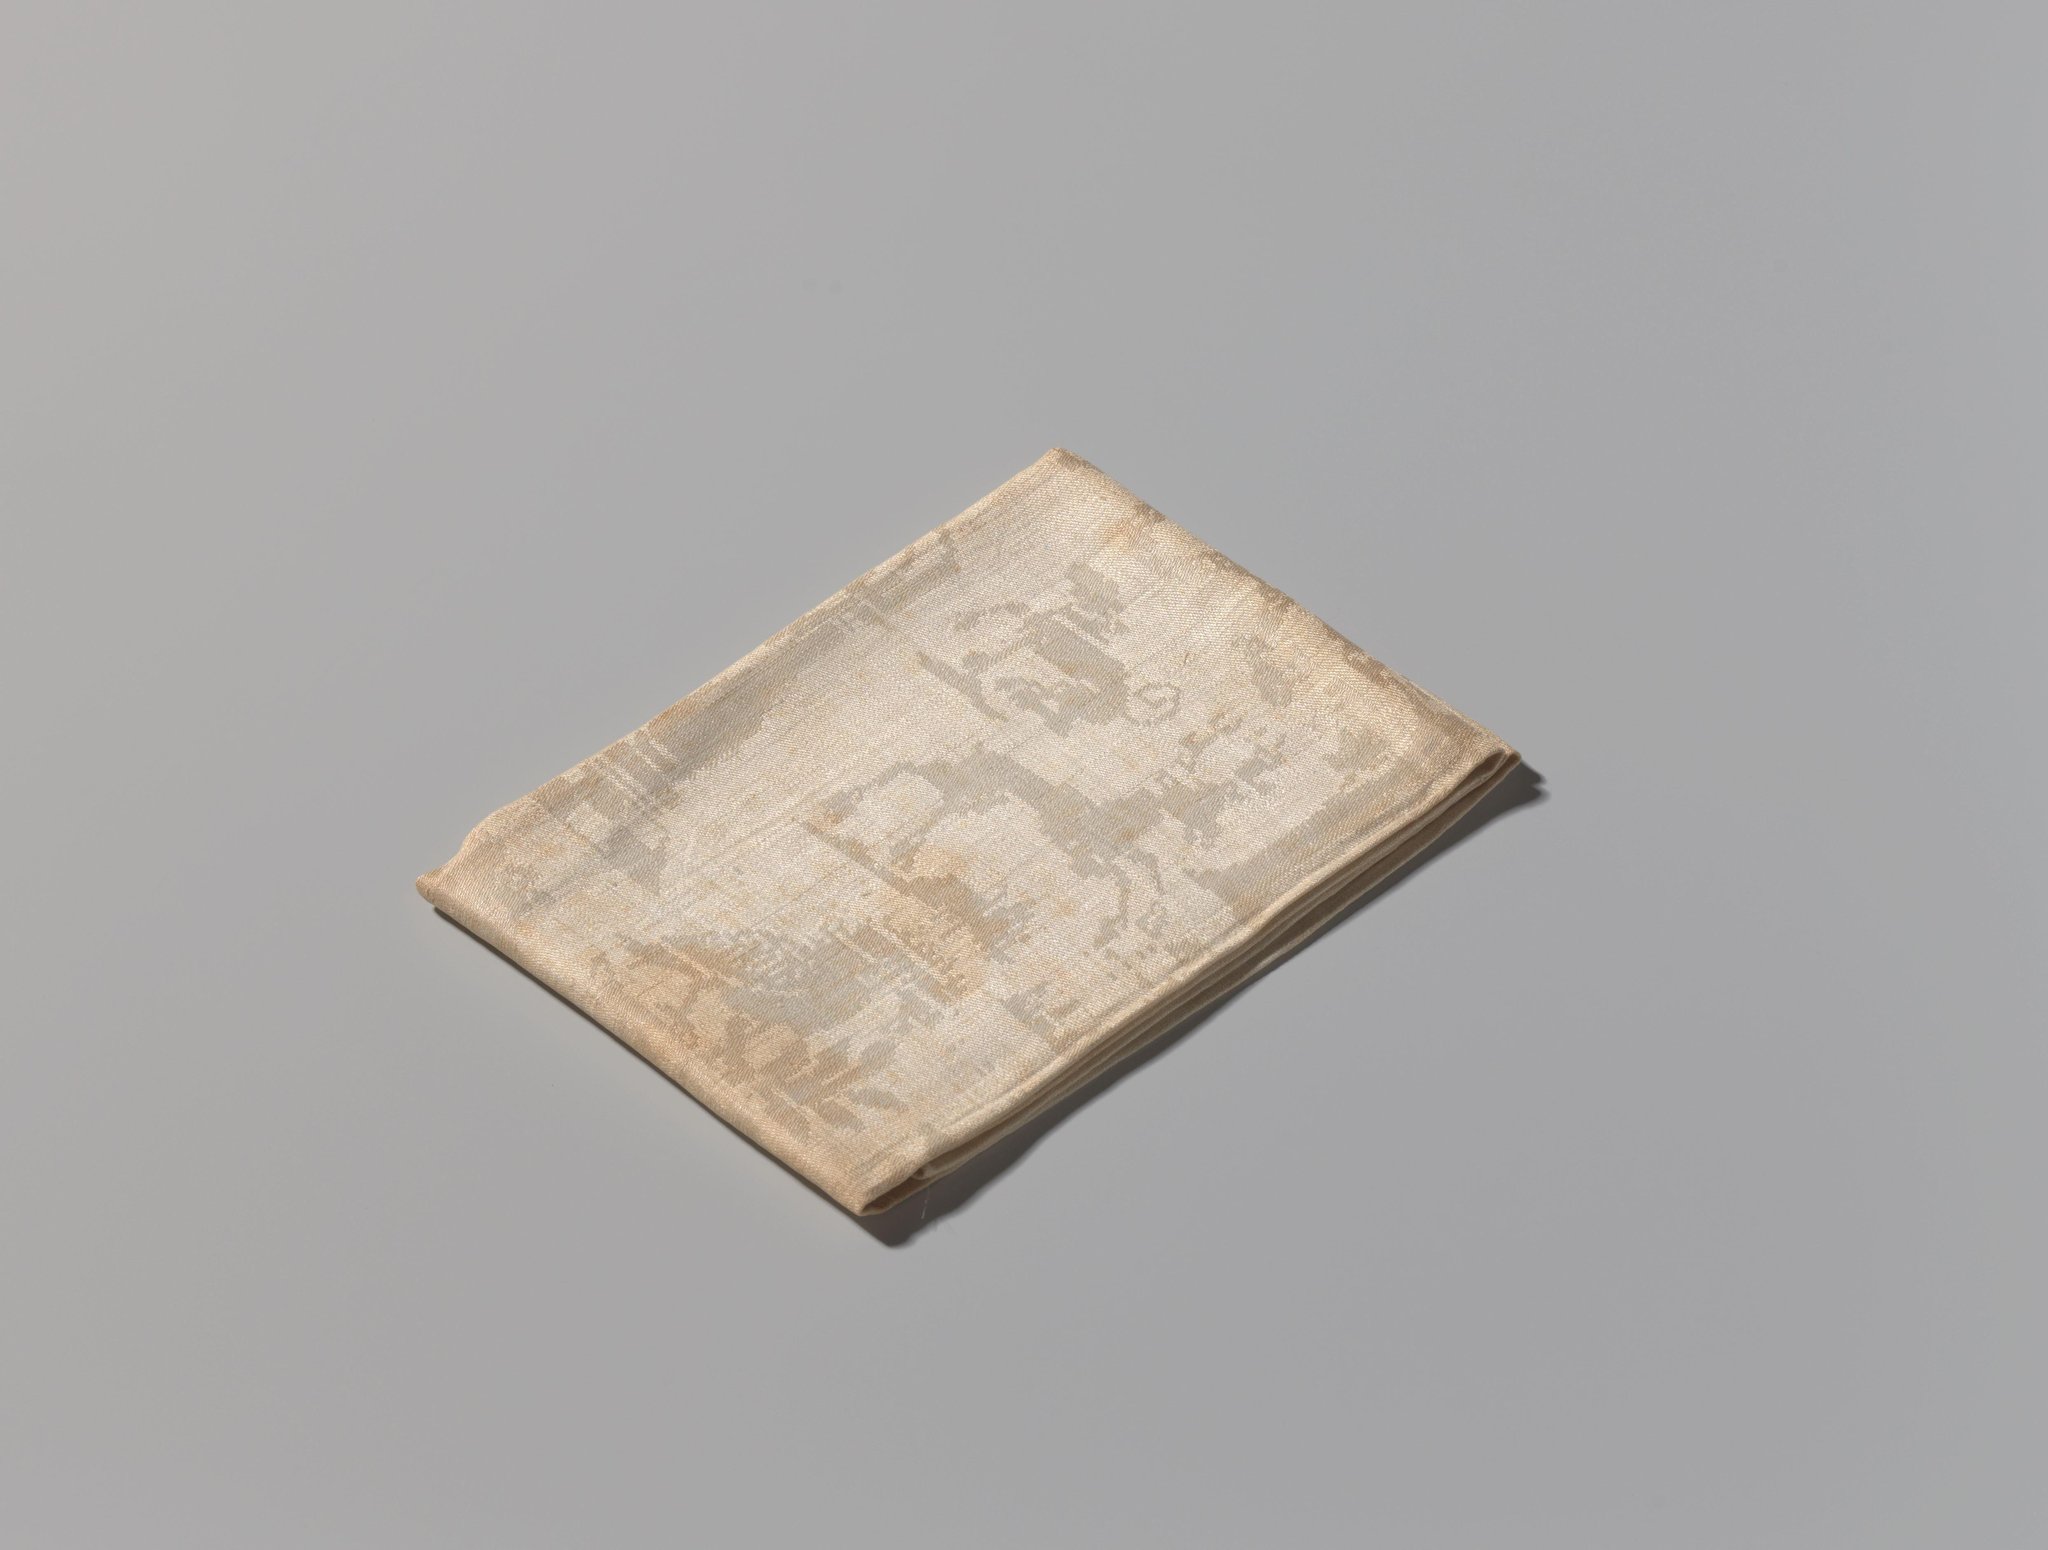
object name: napkin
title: Servet met Orpheus te midden van de dieren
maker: Anonymous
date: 1650-1680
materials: linen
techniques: damask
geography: germany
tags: orpheus playing the lyre: trees and rocks move, beasts and birds are enchanted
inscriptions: mark: ‘IH’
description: Servet van linnendamast met Orpheus en de dieren. Middenveld: In een zuilengalerij van een koepelvormig gebouw speelt een man op een lier (Orpheus ?). De rest van het vlak wordt gevuld door allerlei dieren, daartussen bomen. Staande randen: geslingerde ranken met bloemen, bladeren en vruchten.